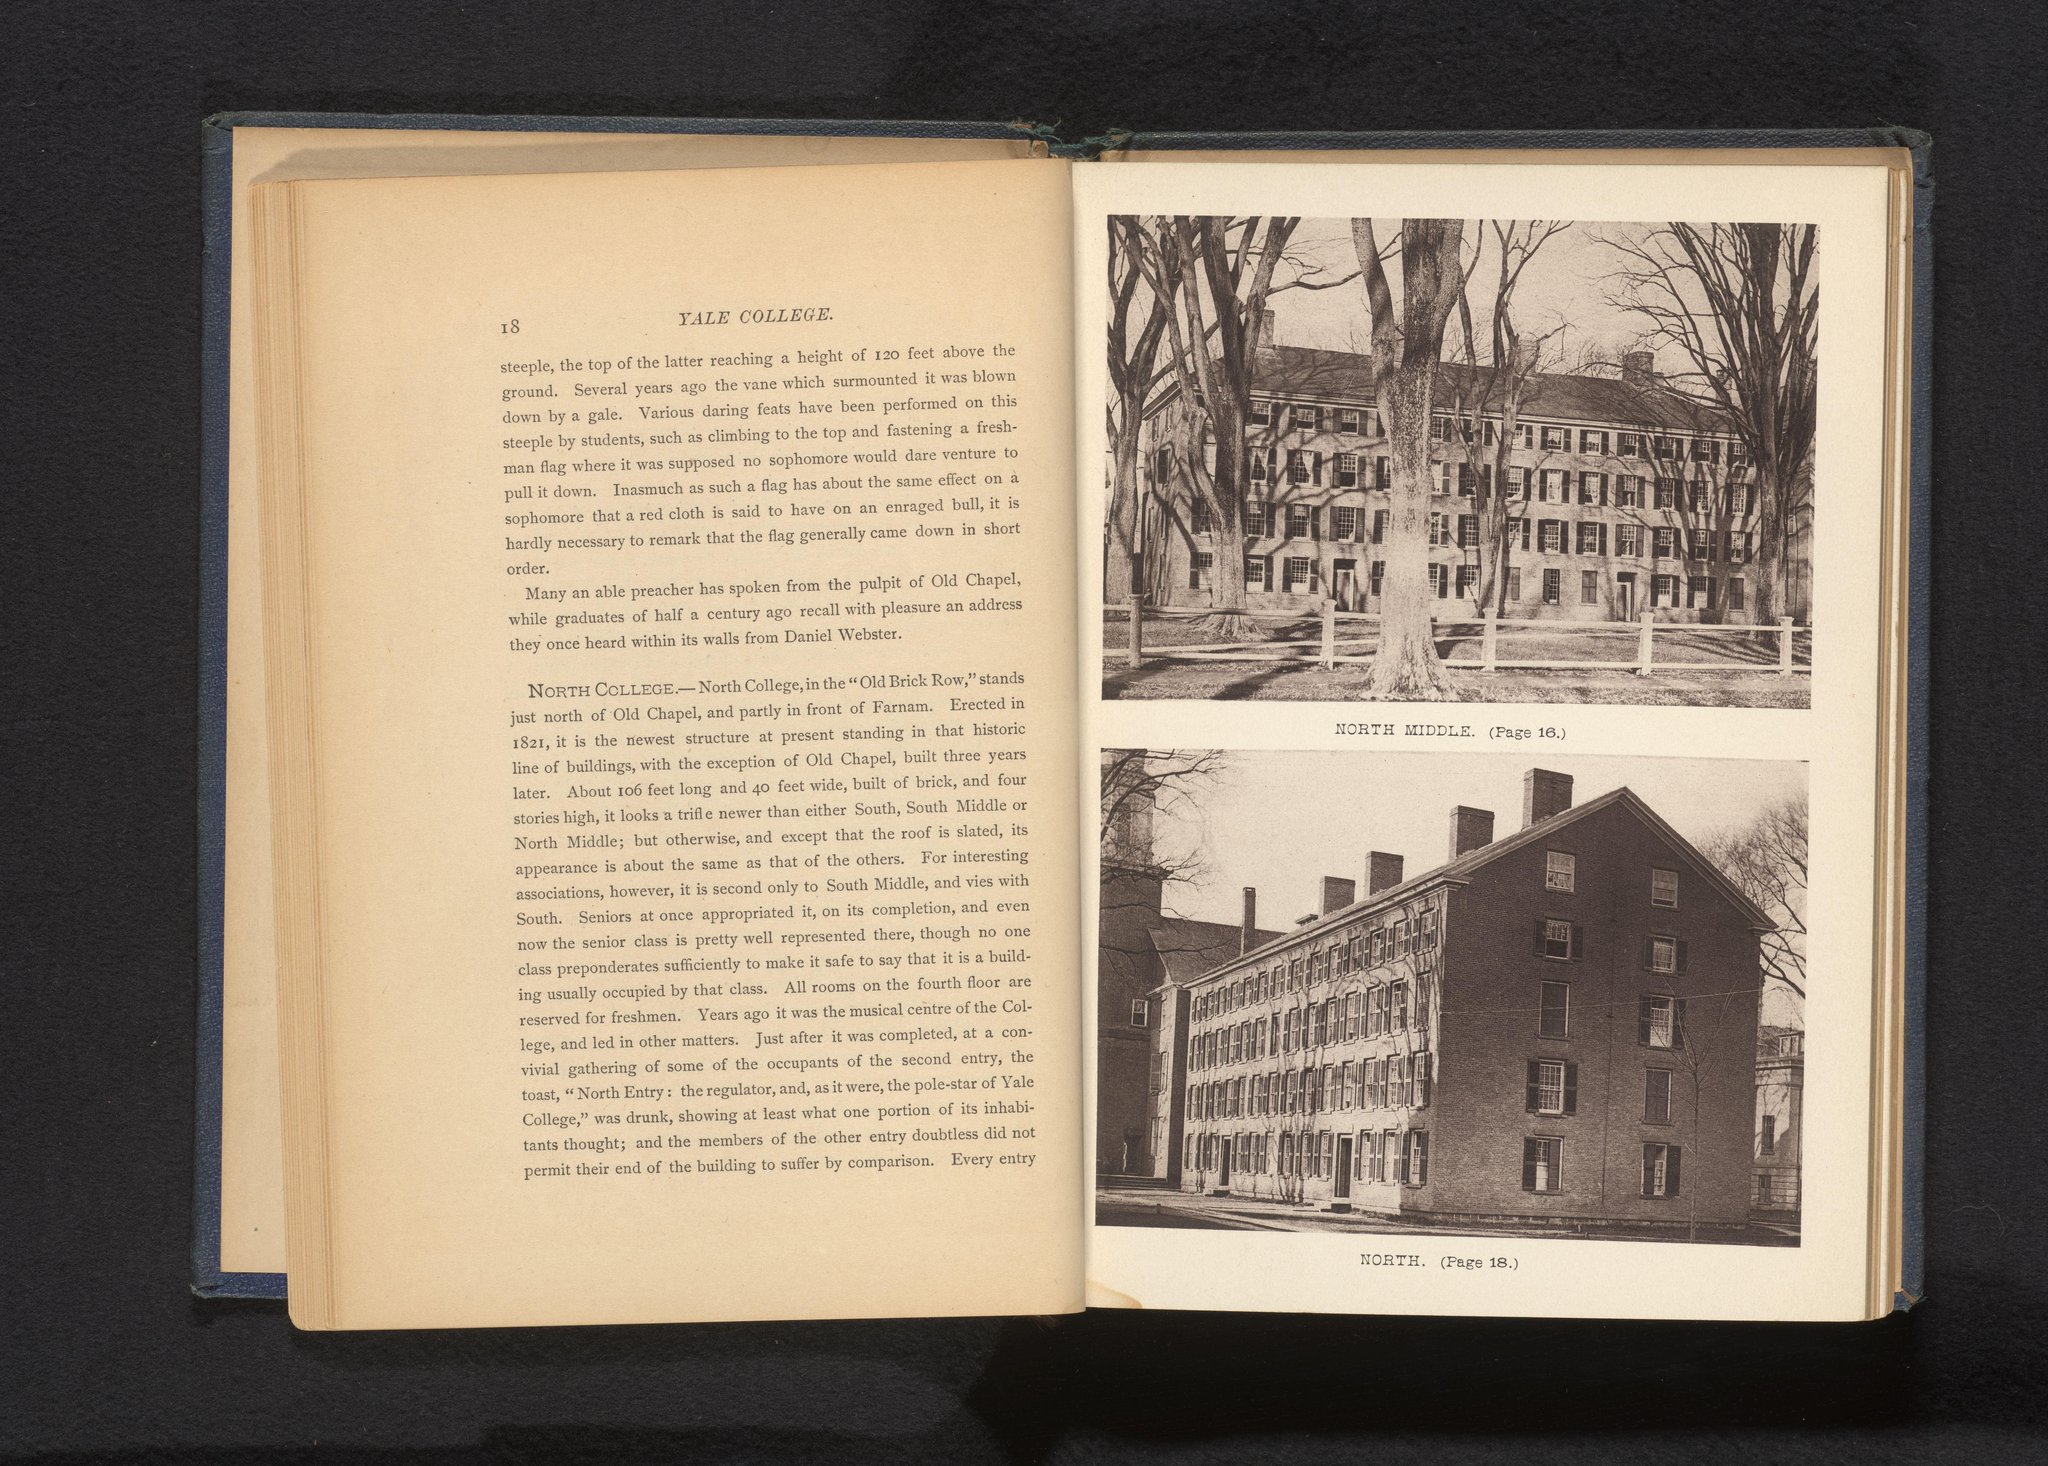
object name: page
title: North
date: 1872-1882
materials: paper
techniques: photograph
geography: yale university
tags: university, façade (of house or building)